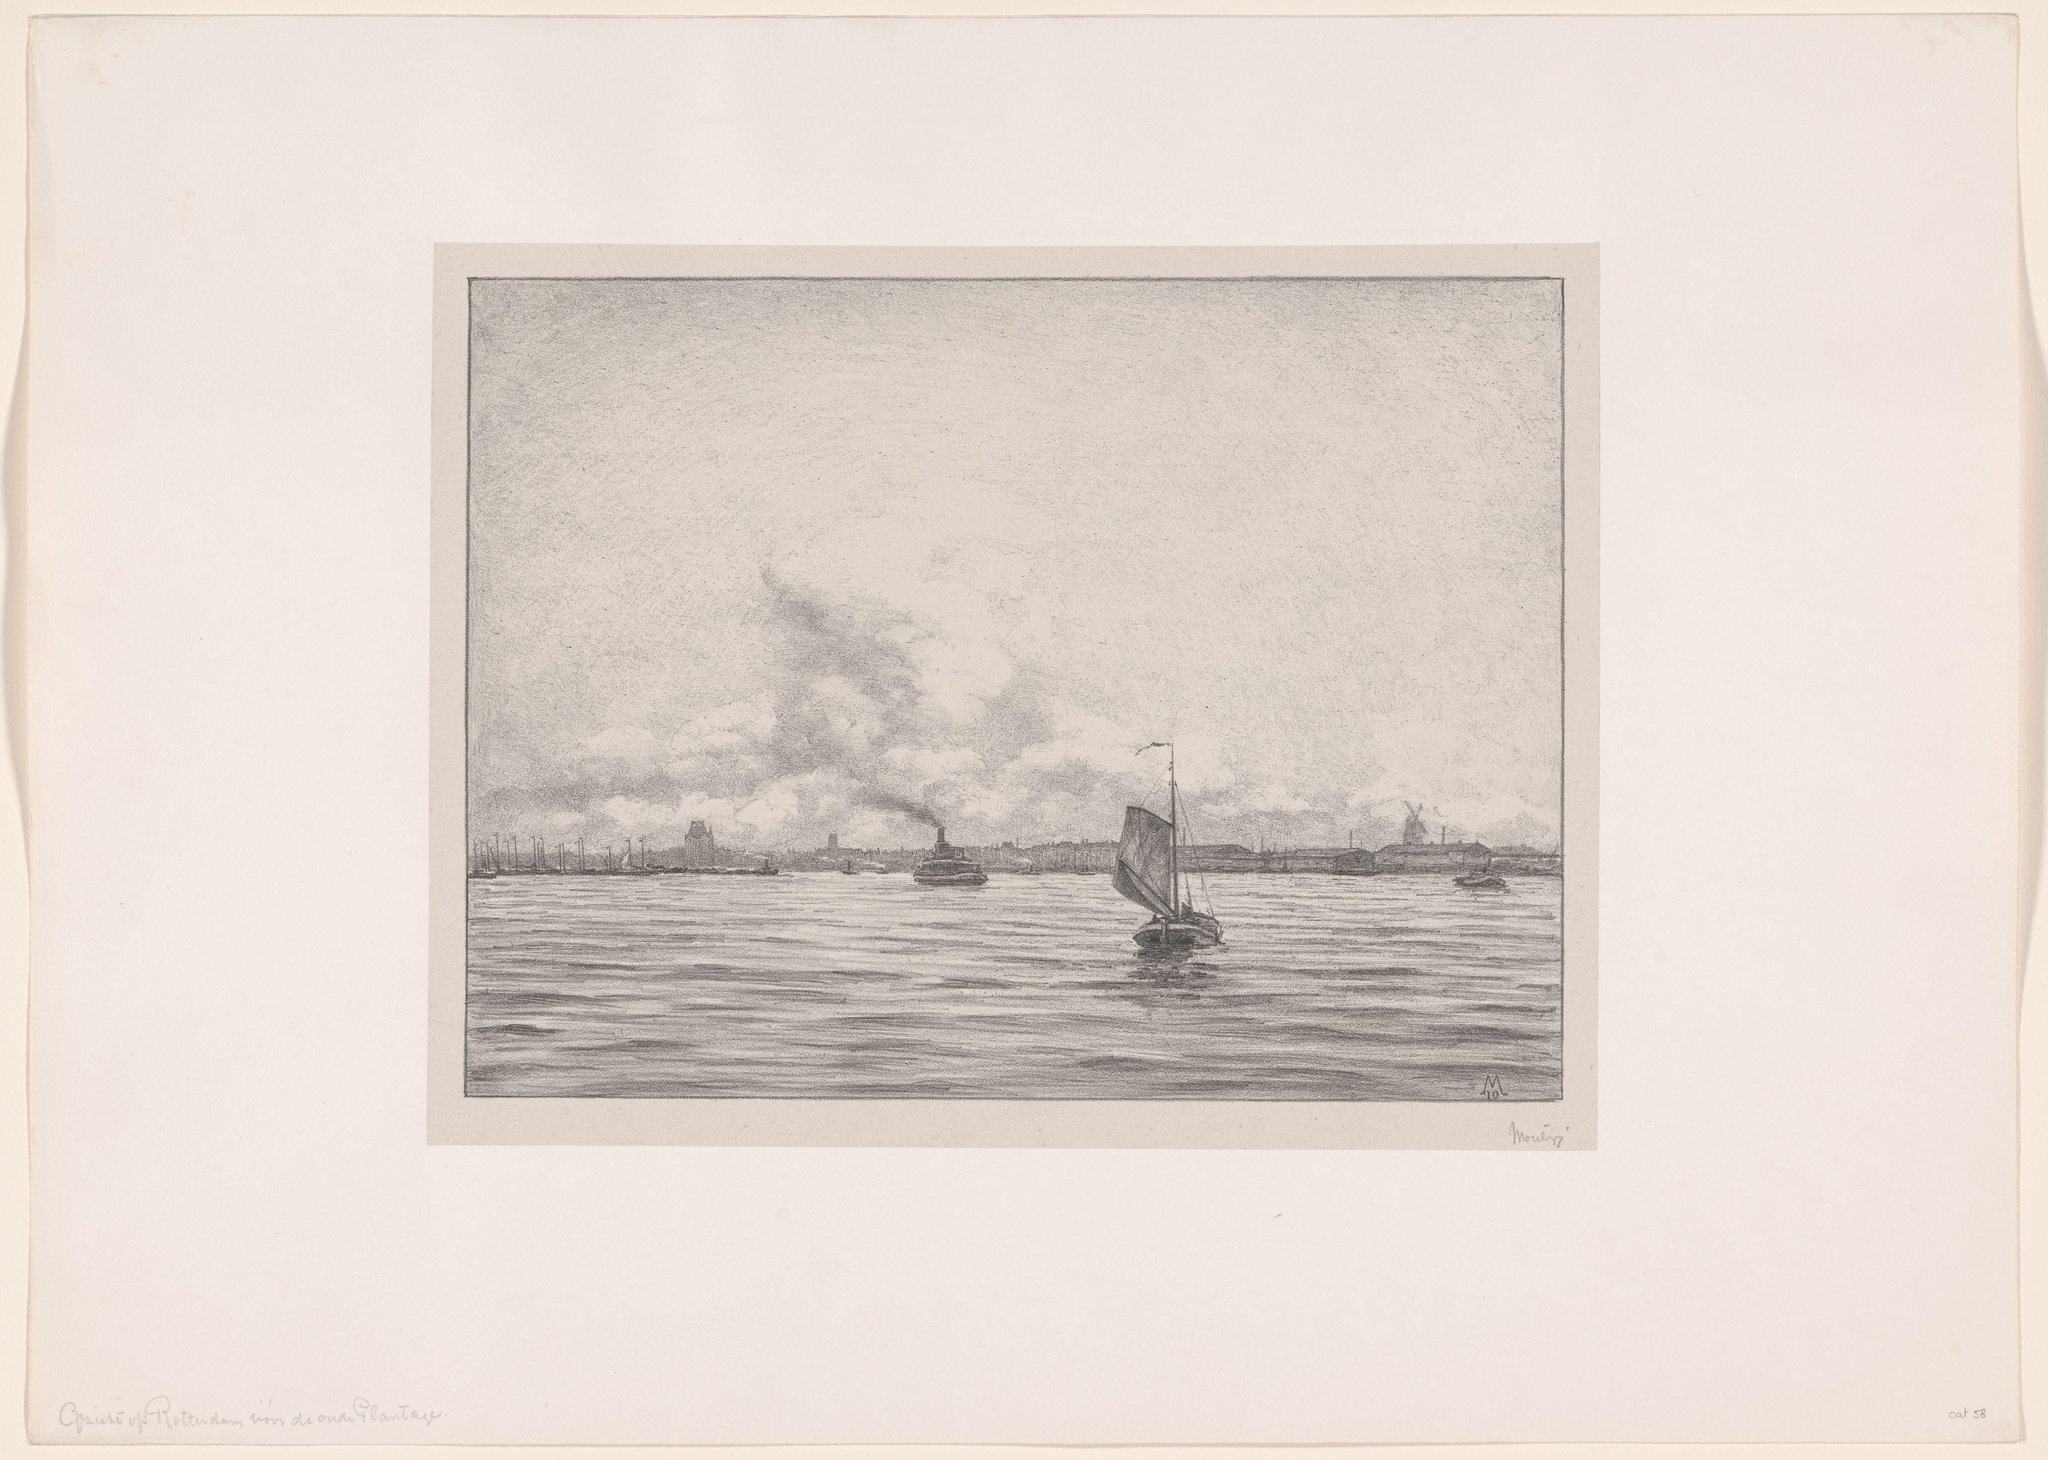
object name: print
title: De Boompjes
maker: simon moulijn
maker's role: draughtsman, print maker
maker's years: 1866-1948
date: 1910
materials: paper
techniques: lithograph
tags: sailing-ship, sailing-boat, prospect of city, town panorama, silhouette of city, rotterdam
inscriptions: annotation: ‘Gezicht op Rotterdam vóór de oude Plantage’, collector's mark: Lugt 2228